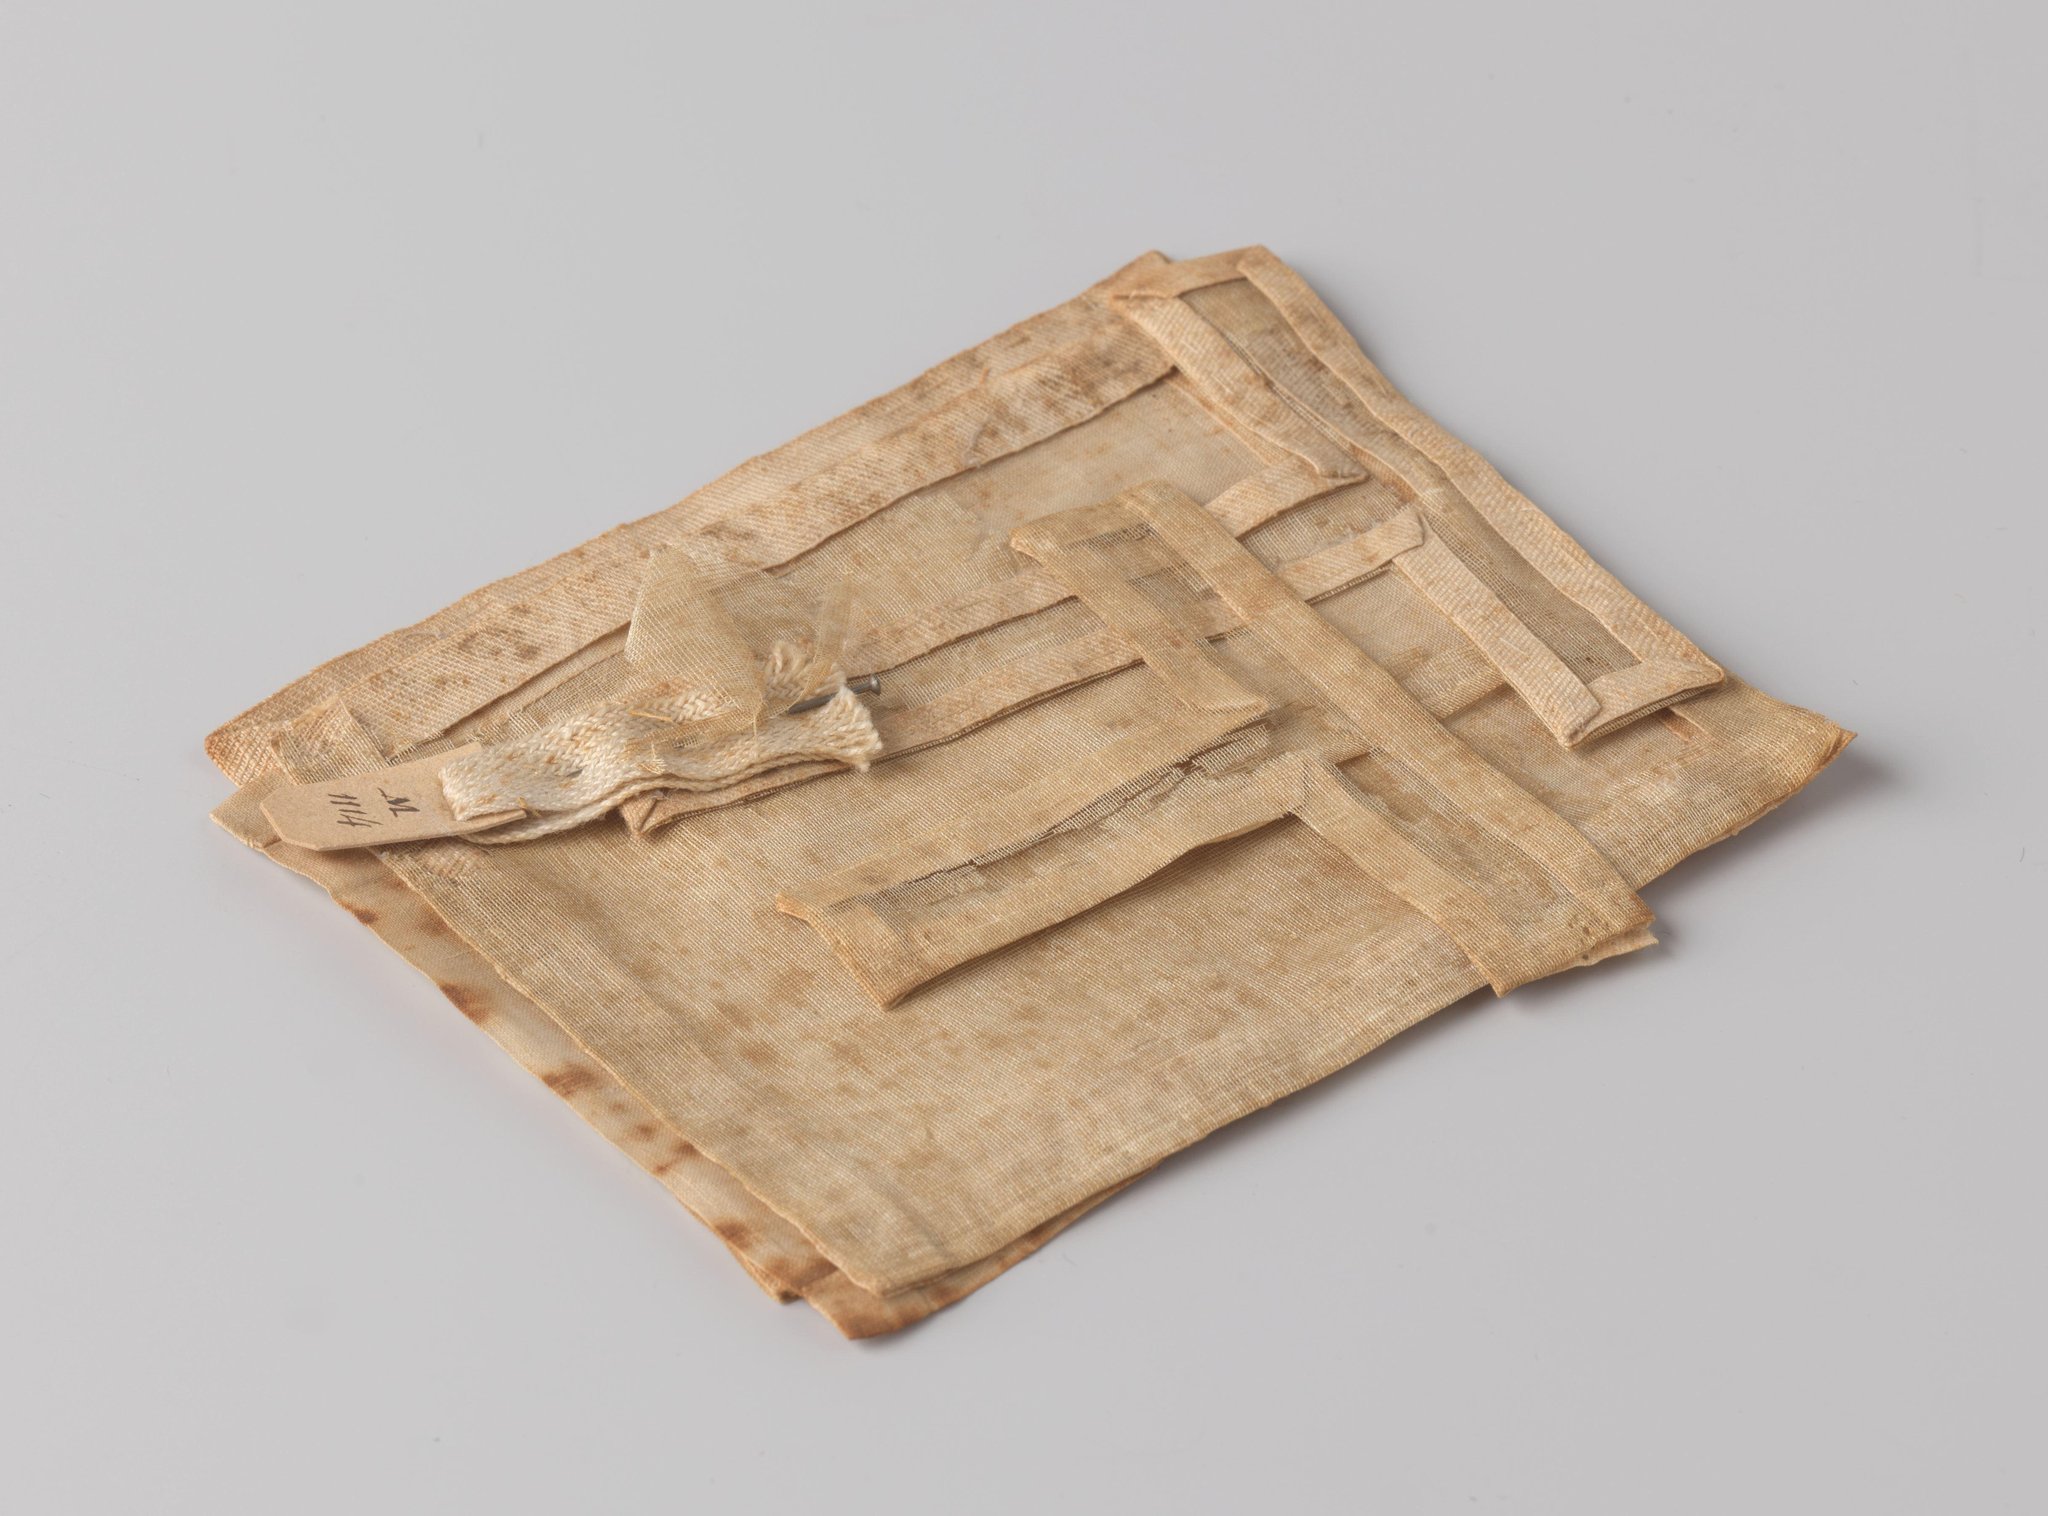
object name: fragment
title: Stuk wit gaas in de vorm van een letter J, dat dient ter versiering van het kussen aan de voordeurklopper, dat in de kraamtijd het geluid dempt.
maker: Anonymous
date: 1600-1950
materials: textile